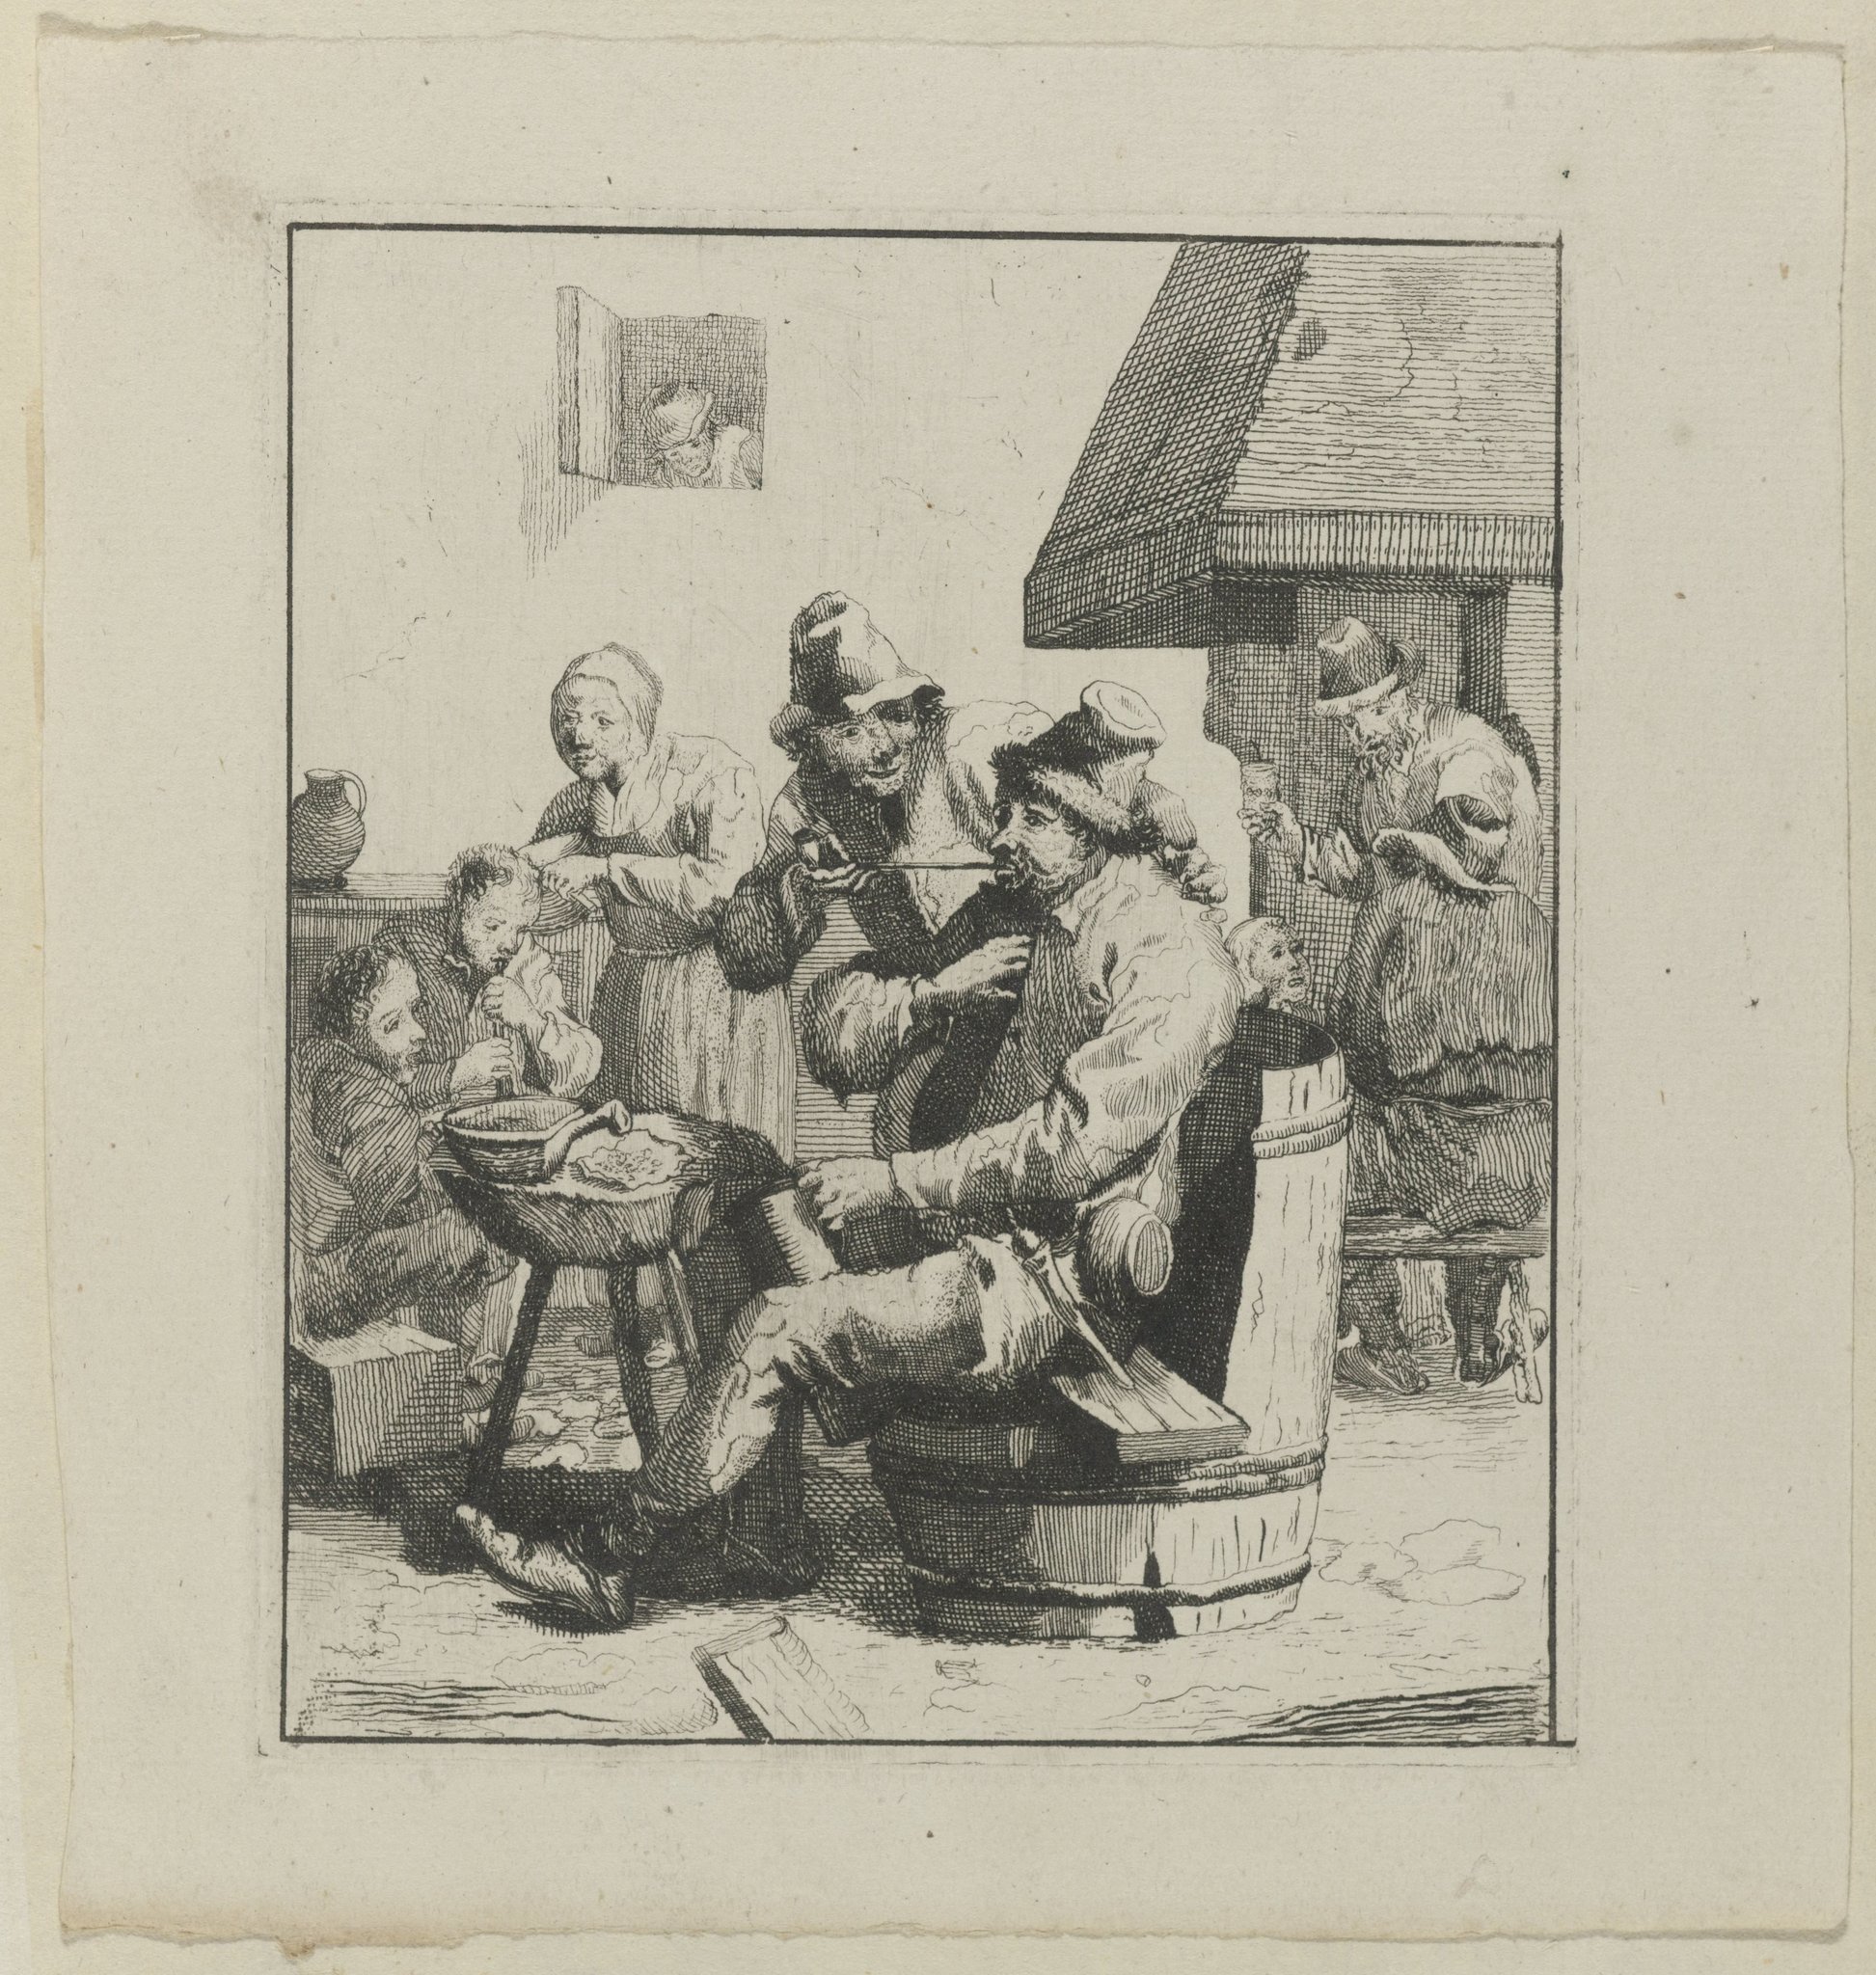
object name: print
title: Gezelschap bij schouw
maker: Anonymous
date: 1600-1699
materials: paper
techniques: etching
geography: netherlands